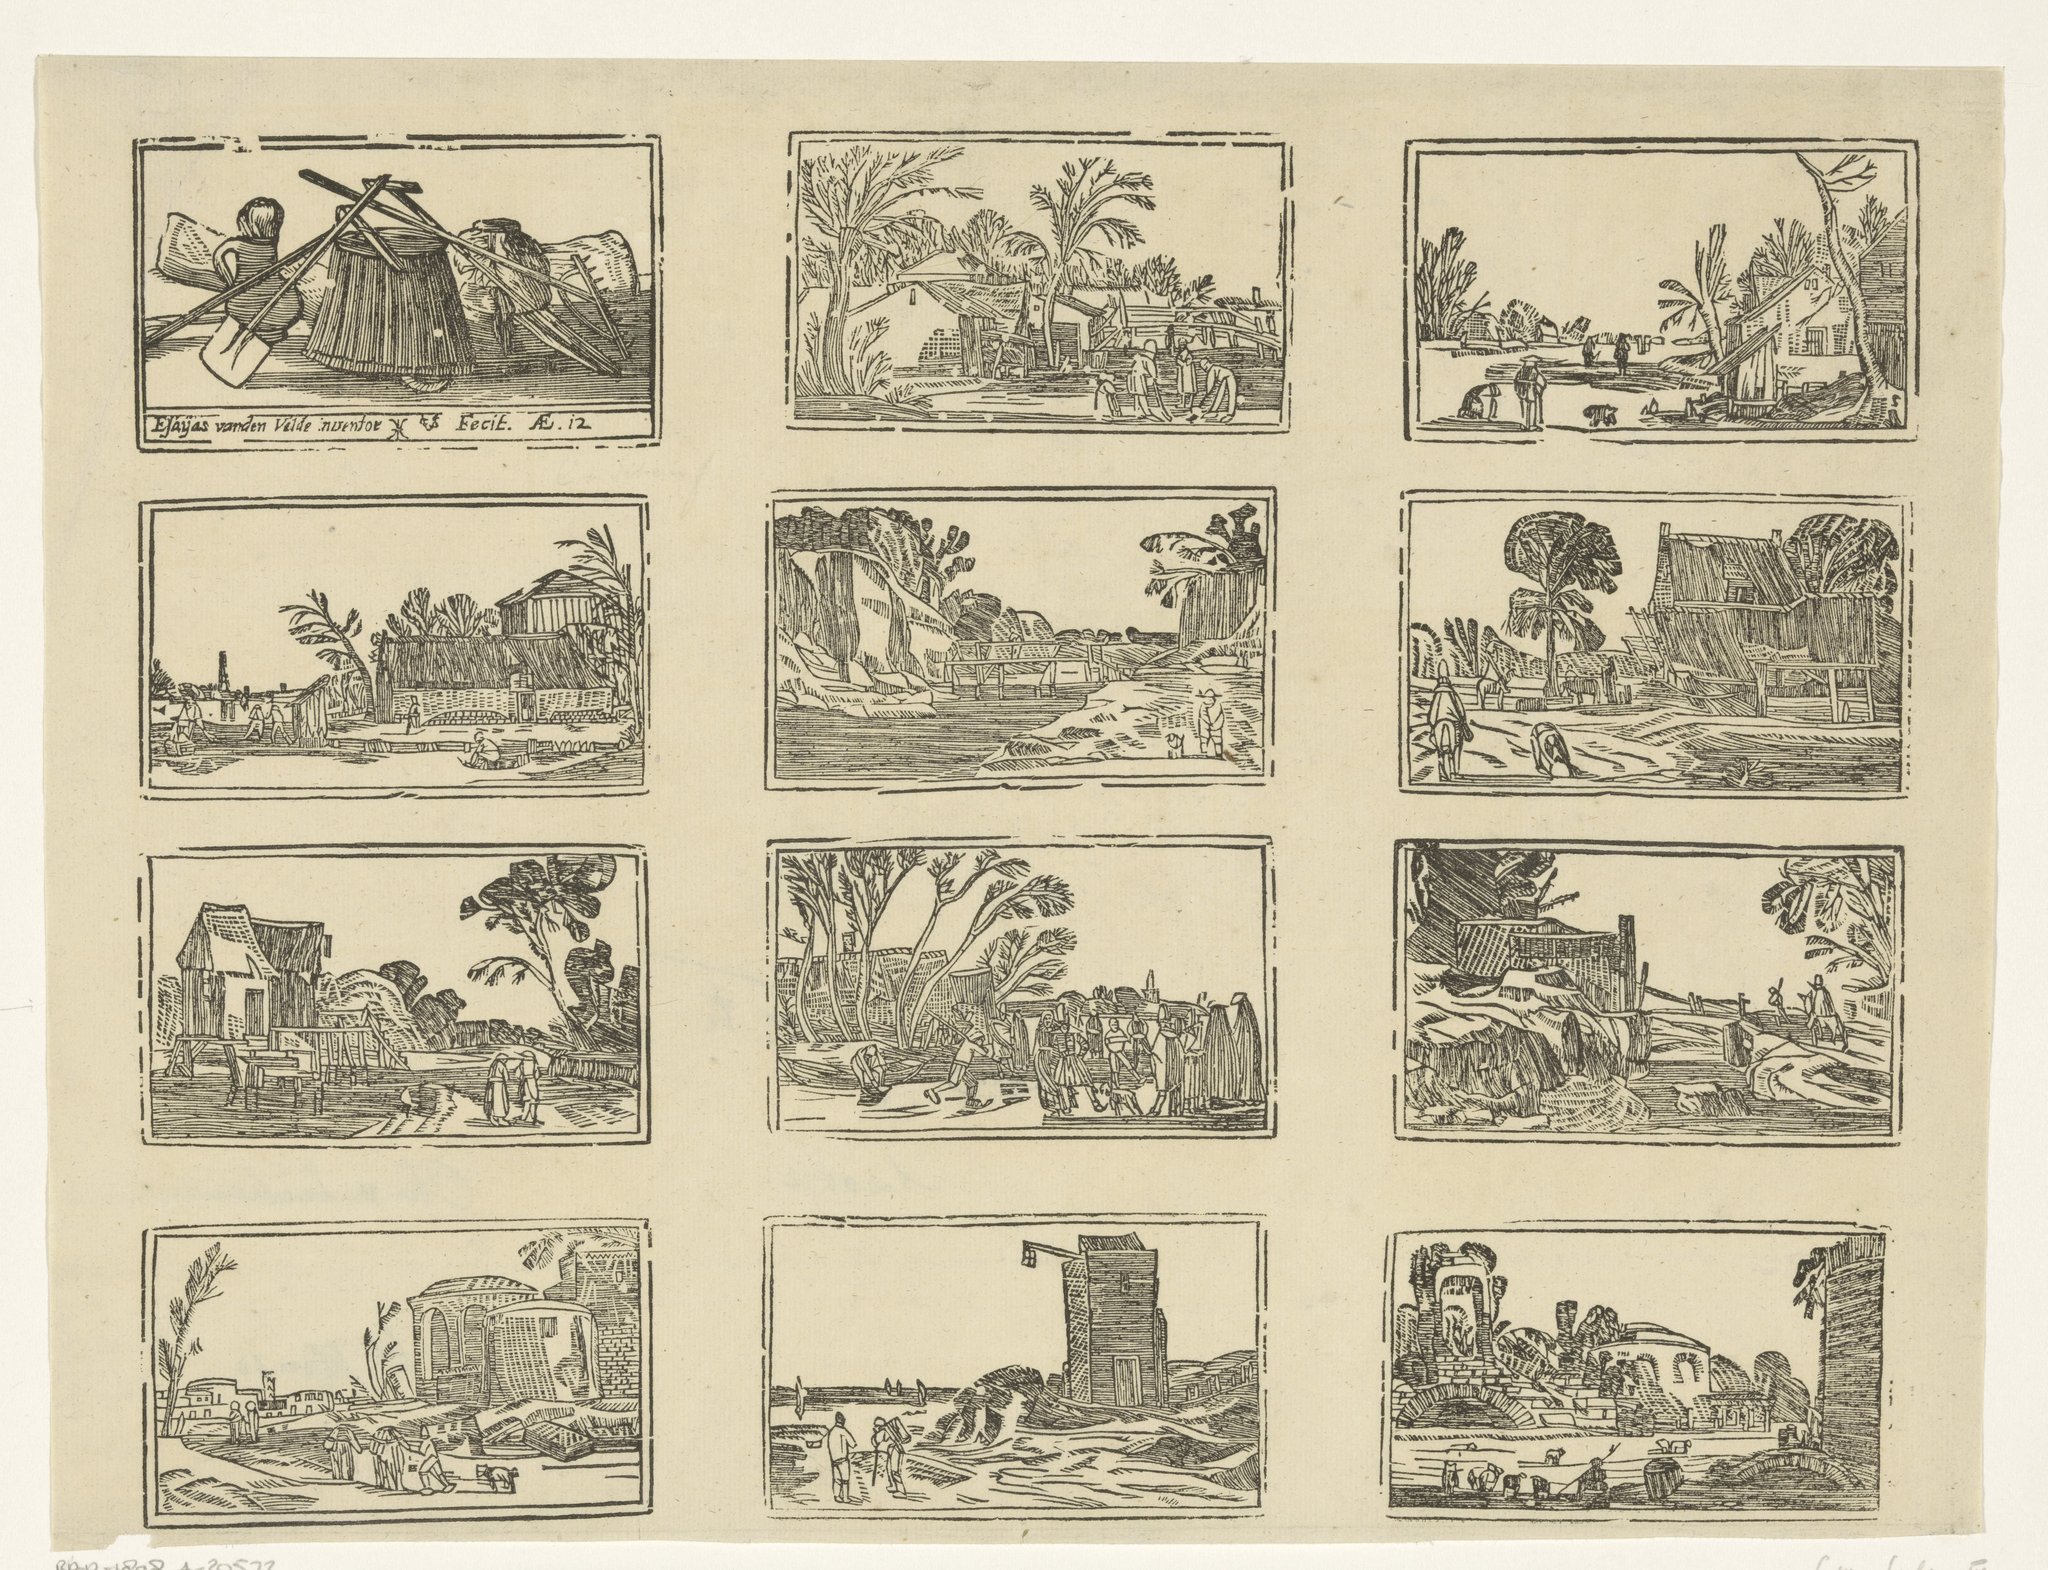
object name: print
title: Elf landschappen en een stilleven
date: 1652-1698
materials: paper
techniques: woodcut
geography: netherlands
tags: landscapes (+ landscape with figures, staffage), still life of miscellaneous objects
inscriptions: collector's mark: Lugt 964